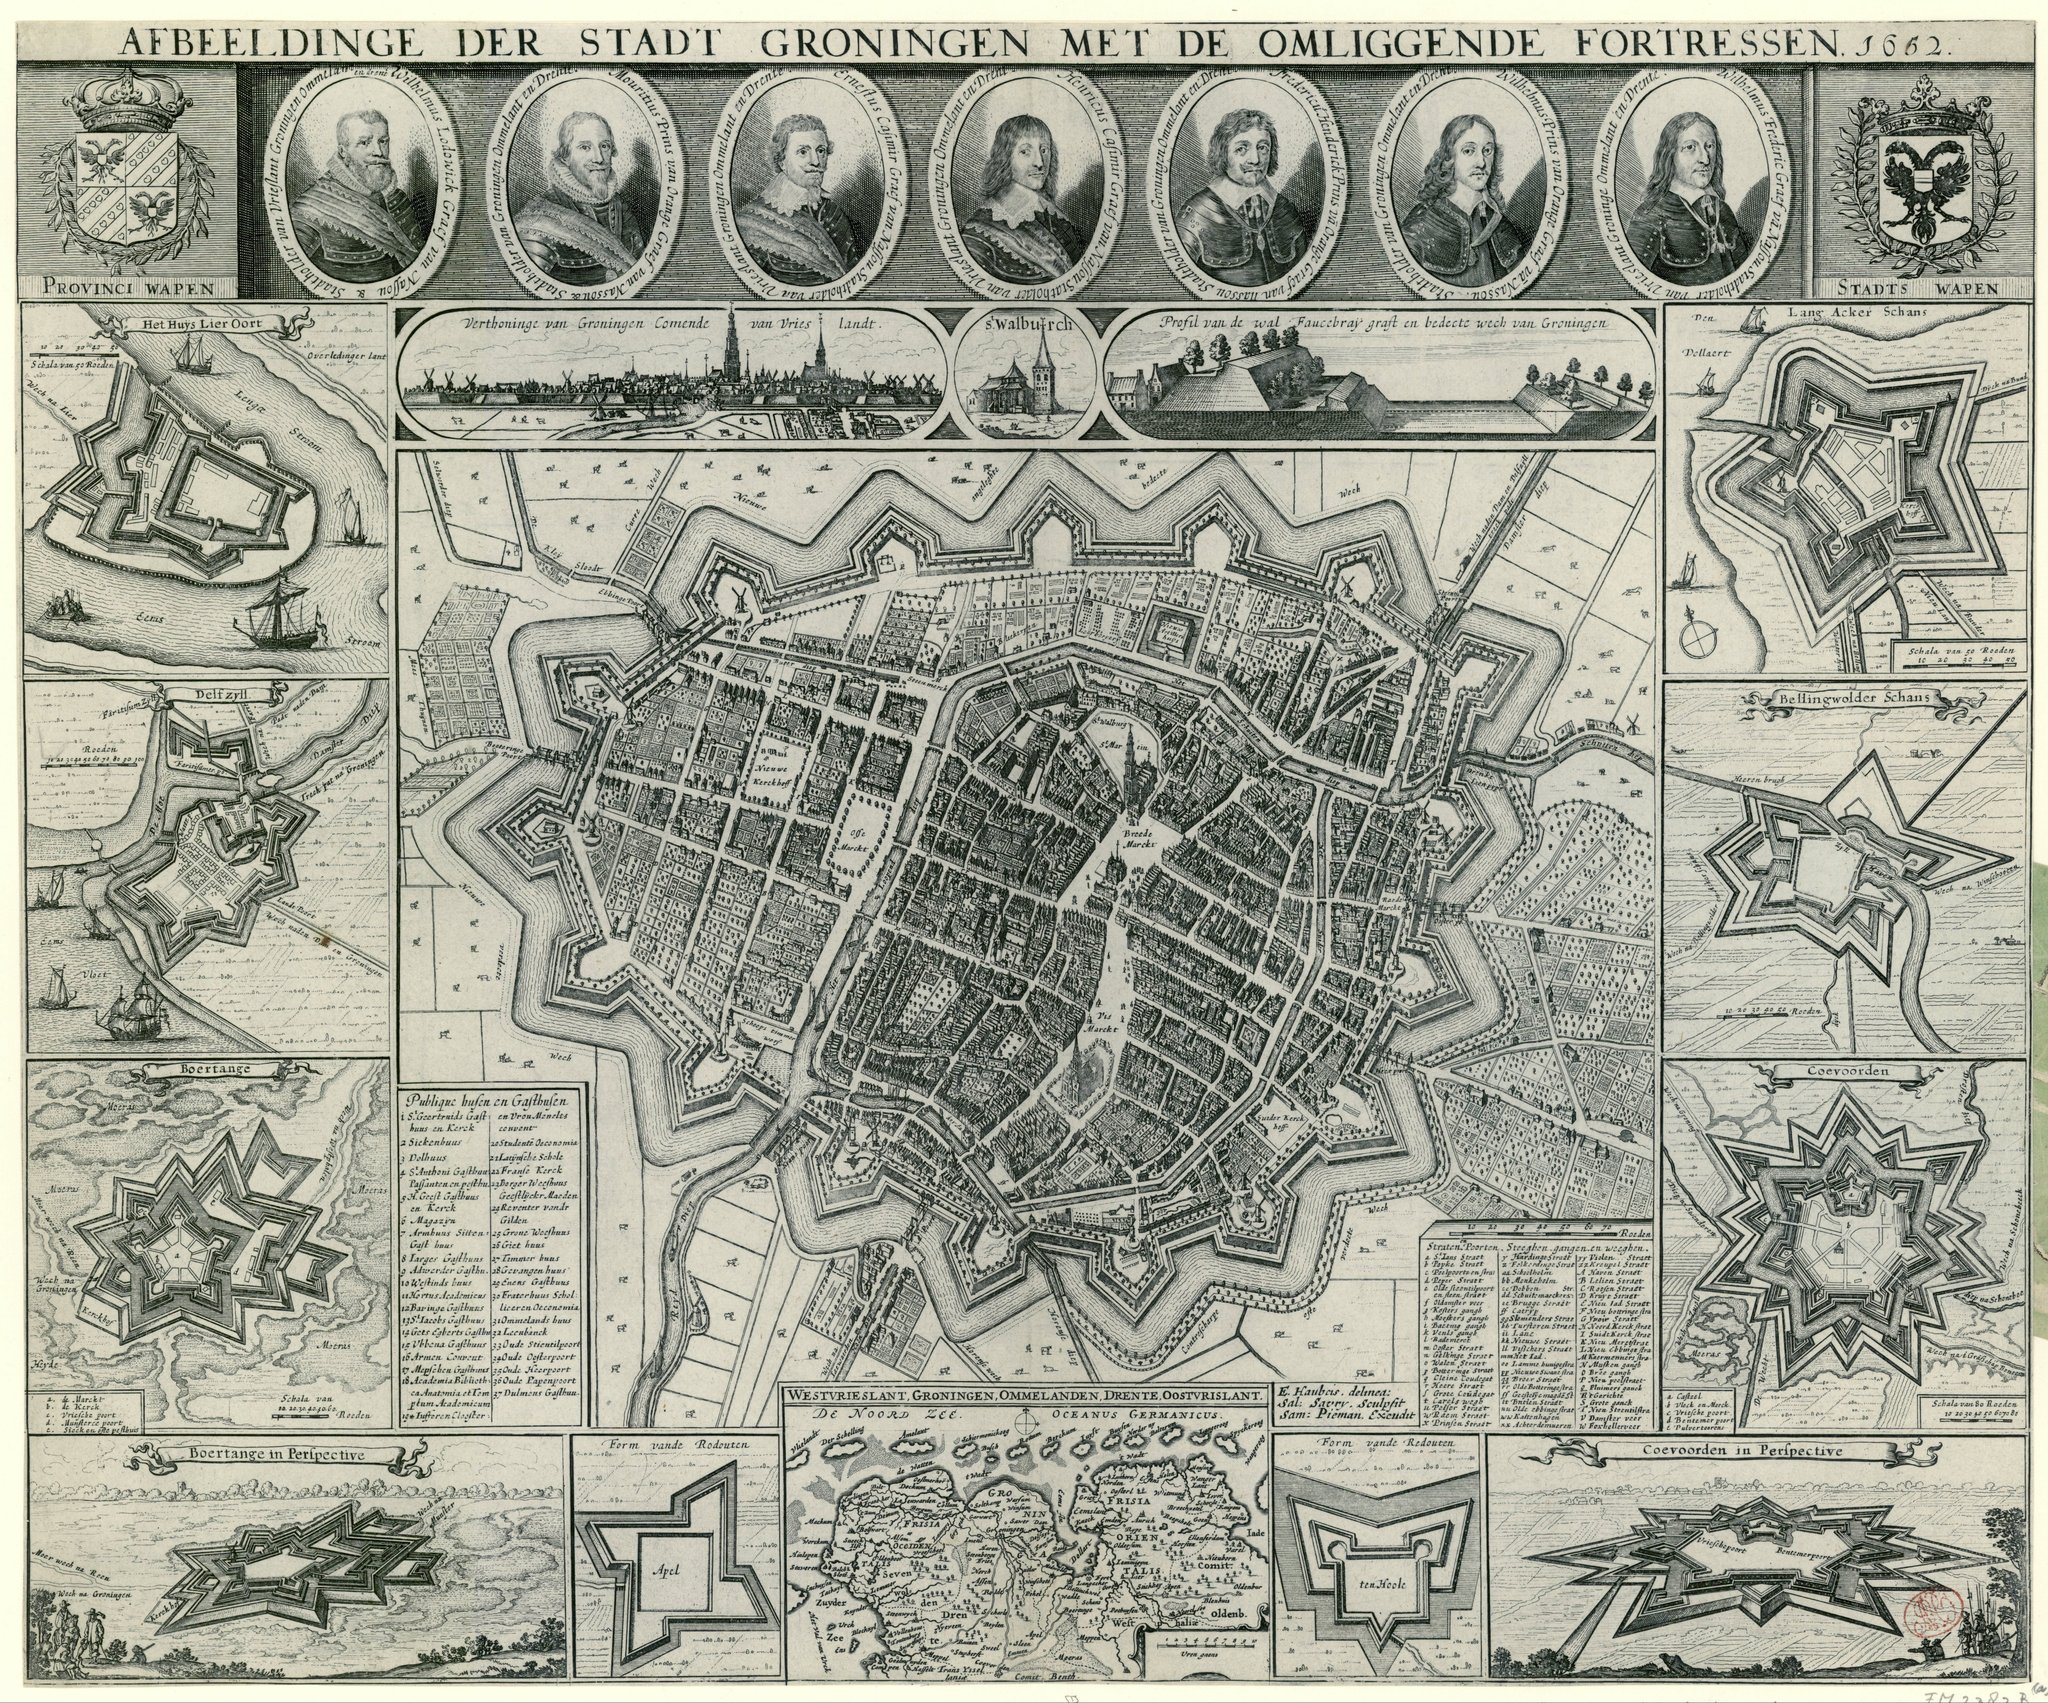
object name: map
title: Kaart van Groningen, 1672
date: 1652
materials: paper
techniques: engraving, etching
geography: northern netherlands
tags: delft, frederick henry (prince of orange), william ii (prince of orange), the hague, maurice (prince of orange), willem lodewijk graaf van nassau-dillenburg, ernst casimir graaf van nassau-dietz, arnhem, hendrik casimir i graaf van nassau-dietz, maps of cities, groningen (province)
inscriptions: collector's mark: Lugt 195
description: Kaart van de stad Groningen. In het midden een plattegrond van de stad, hieromheen voorstellingen van tien vestingen in de omgeving. Onderaan ook een kaartje van de noordelijke Nederlandse provincies. Bovenaan portretten van zeven stadhouders van Groningen. De kaart zelf dateert uit 1652 maar is geactualiseerd door de toevoeging van een getekend blad waarop de approches van de Munsterse en Keulse legers zijn weergegeven tijdens het beleg van de stad in juli-augustus 1672. Dit blad kan als een flap passend over de prent worden gevouwen.